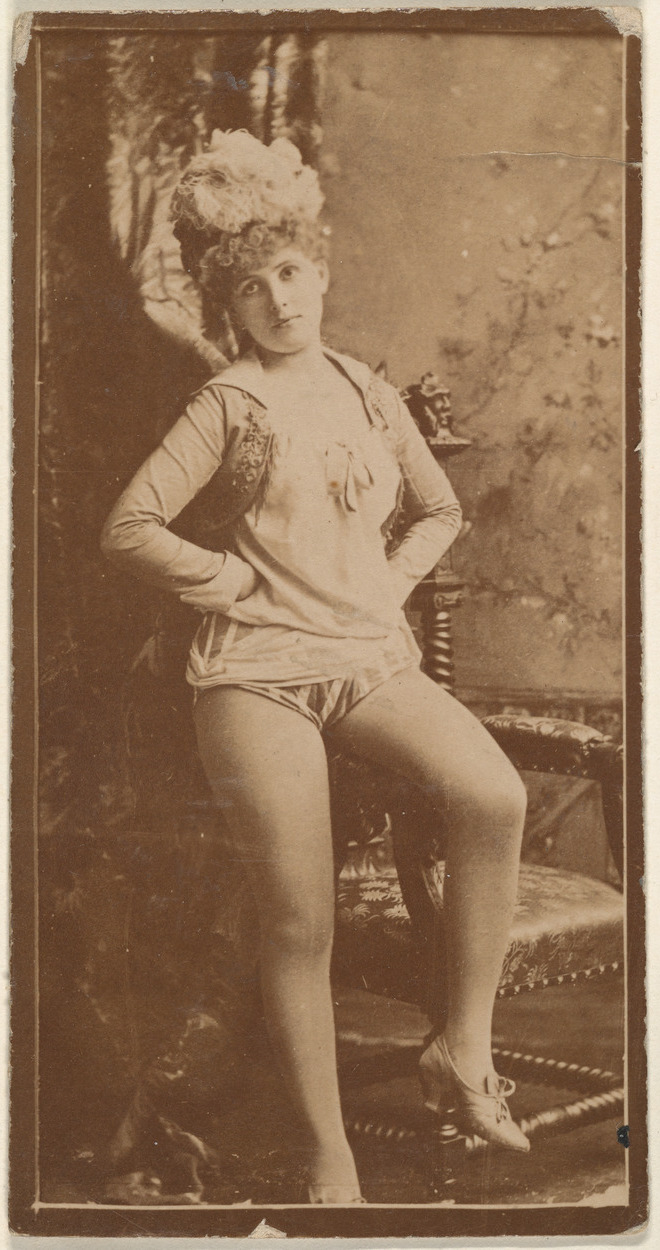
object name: photograph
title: Actress leaning on chair, from the Actresses series (N668)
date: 1888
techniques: albumen silver print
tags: portraits,women,actresses